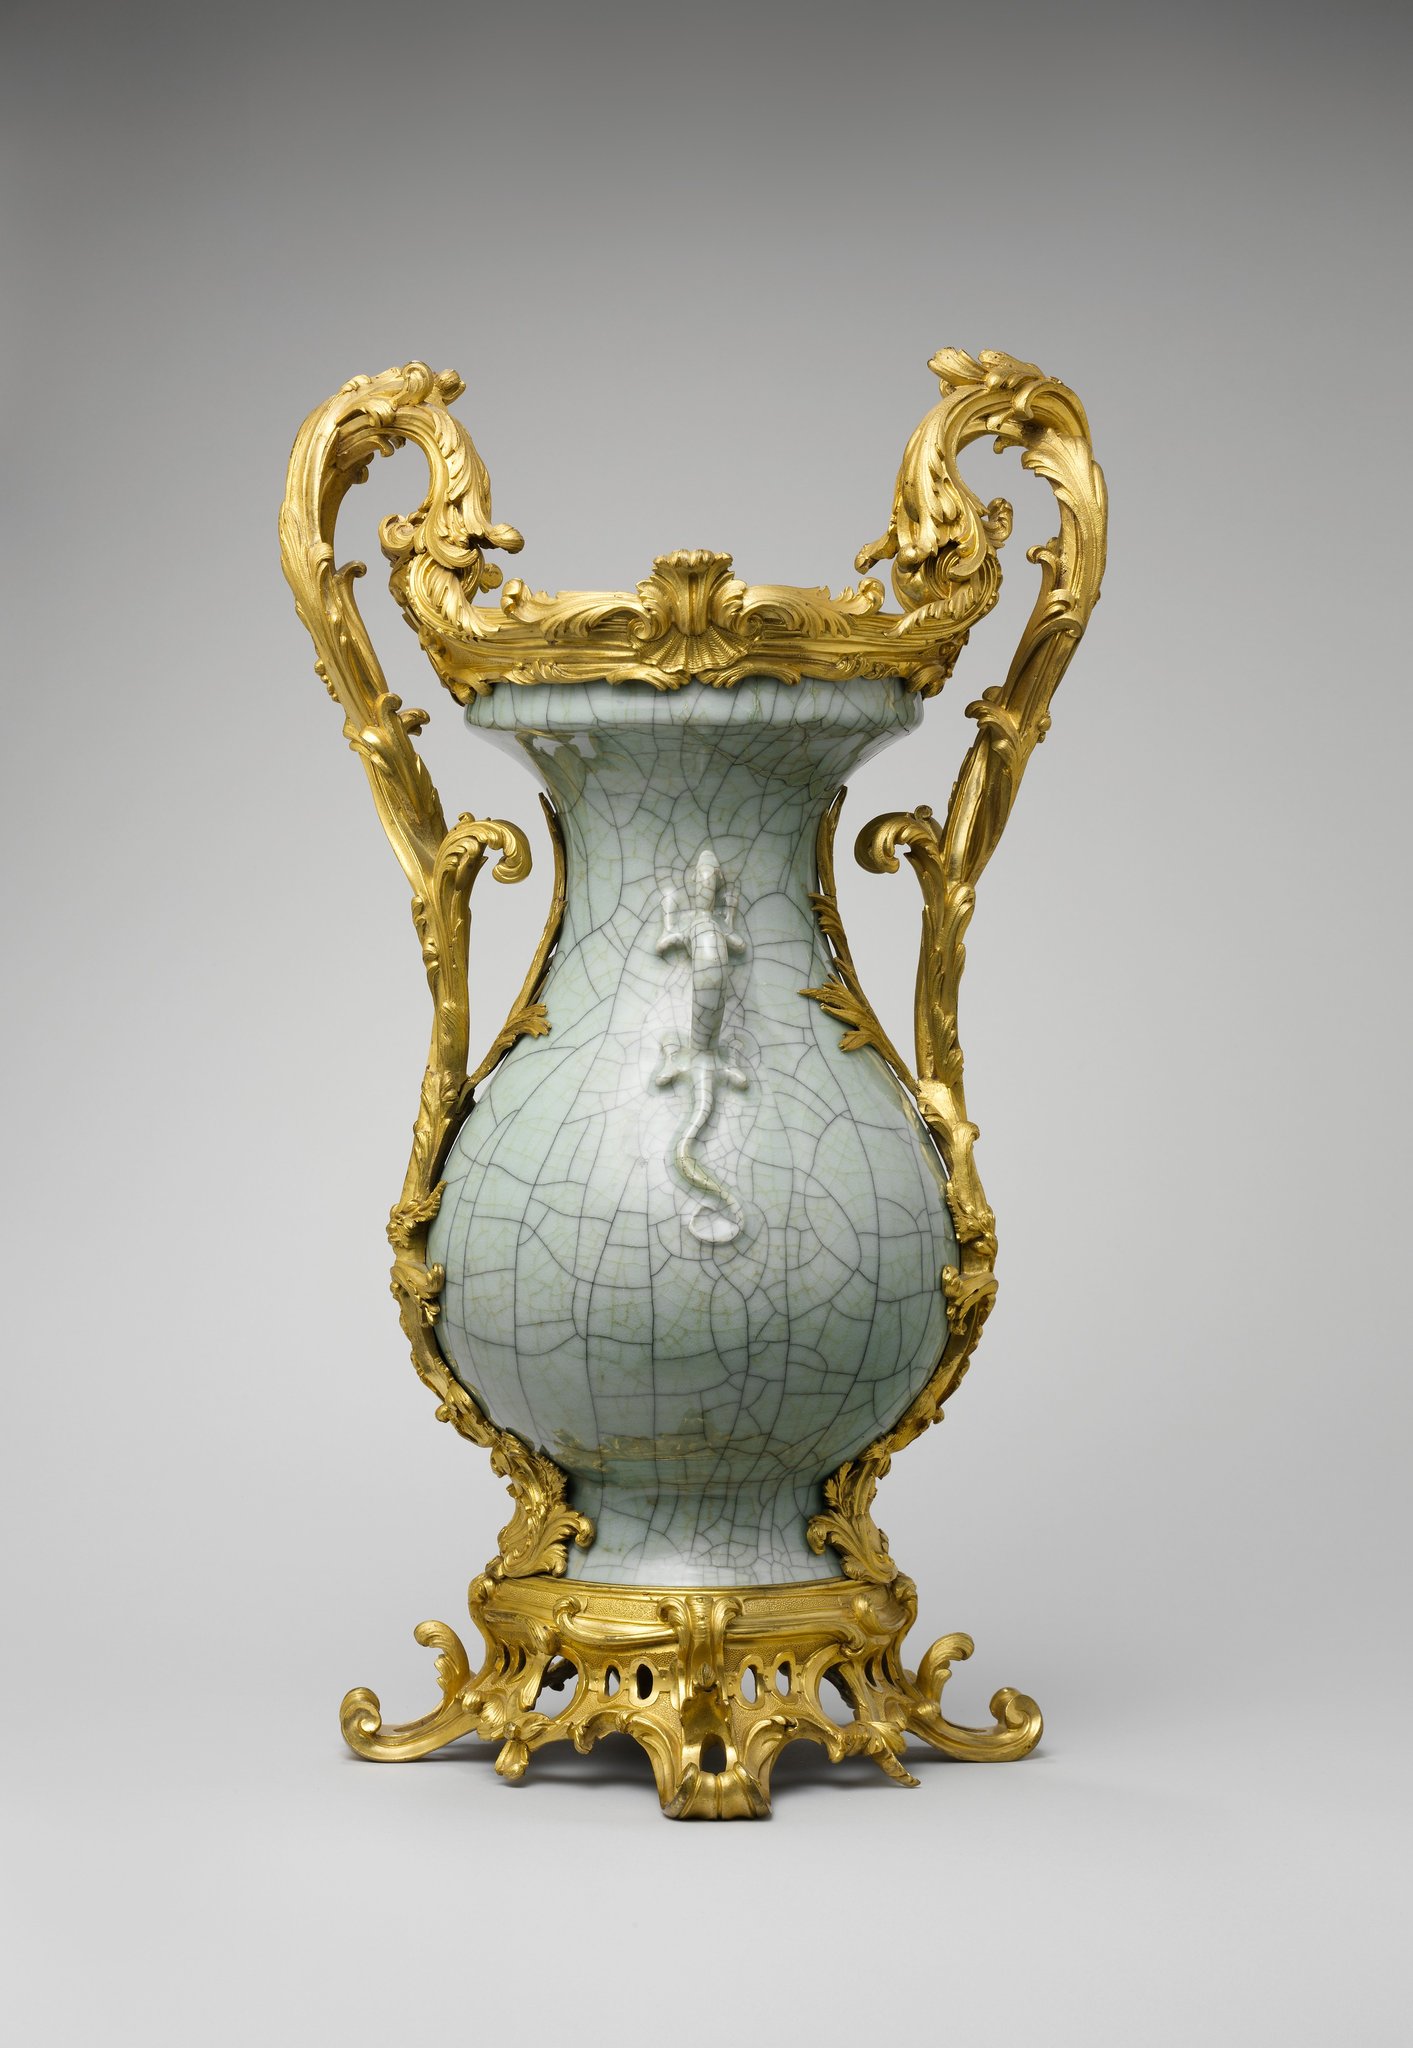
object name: vase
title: Mounted vase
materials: gilt bronze, hard paste porcelain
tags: lizards